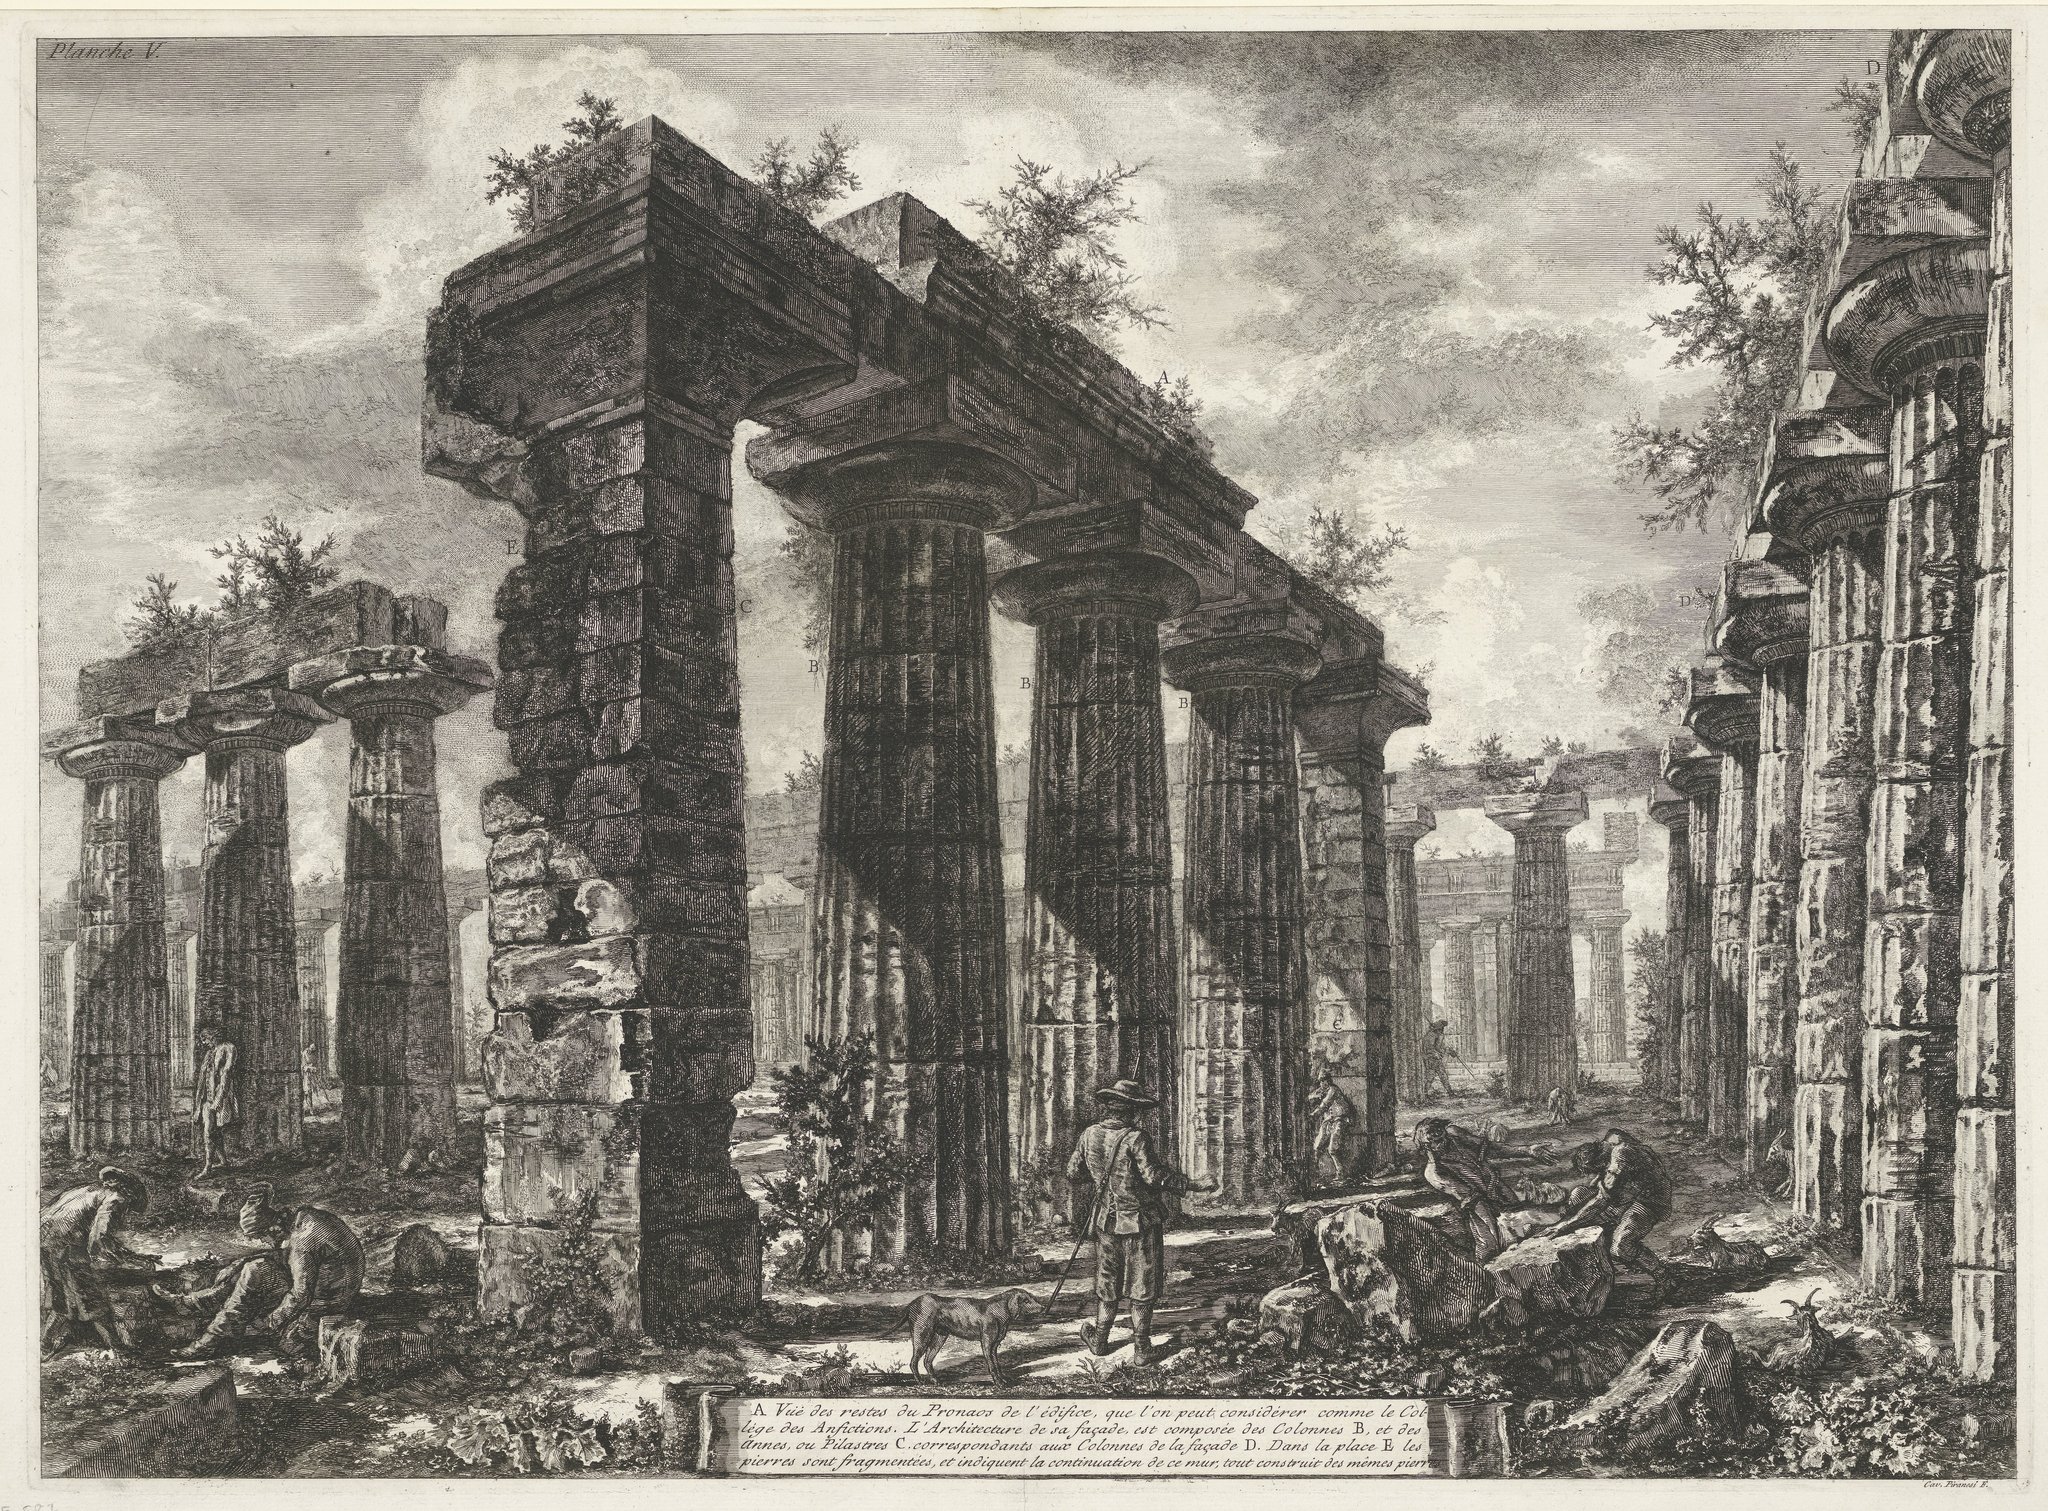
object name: print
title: Basilica di Paestum te Paestum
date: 1778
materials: paper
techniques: etching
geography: rome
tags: ruin of a building ~ architecture, landscape with ruins, temple, shrine ~ roman religion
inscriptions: collector's mark: Lugt 2228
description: Deze prent maakt deel uit van een reeks van 20 prenten (+ titelprent) met gezichten op tempels te Paestum. De gebouwen en de vegetatie op de prenten zijn uitgevoerd door Giovanni Battista Piranesi. De figuren zijn mogelijk uitgevoerd door zijn zoon Francesco.